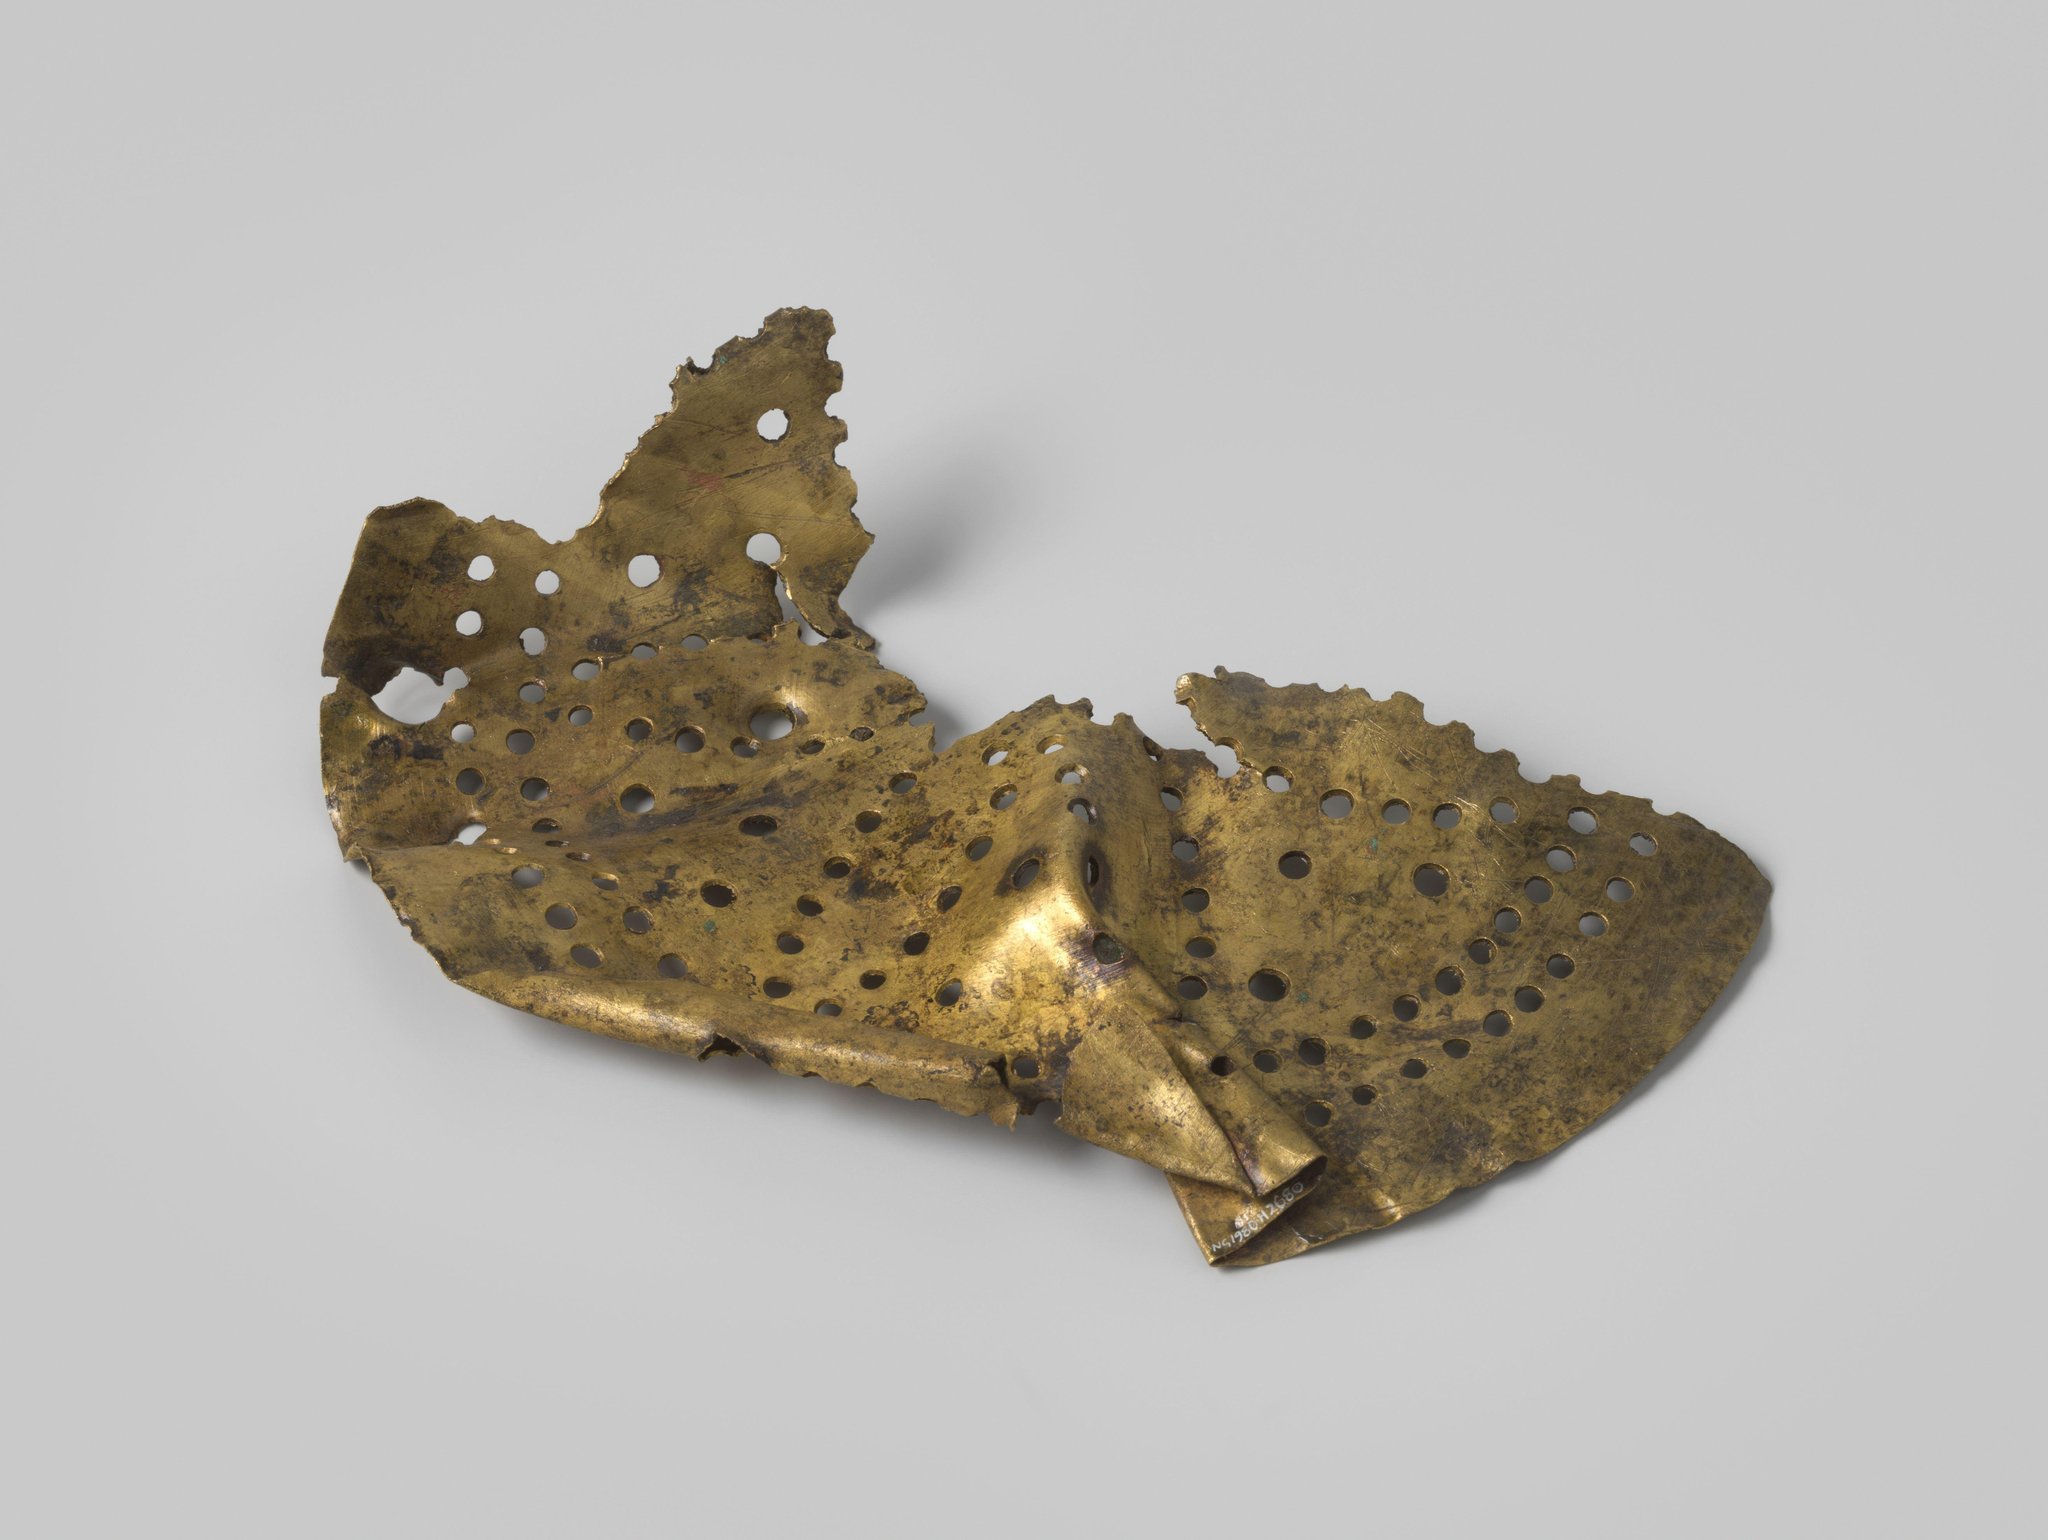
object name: skimmer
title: Fragment schuimspaan uit het wrak van de Oost-Indiëvaarder Hollandia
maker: Anonymous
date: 1700-1743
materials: copper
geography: netherlands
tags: verenigde oostindische compagnie, hollandia (schip), annet